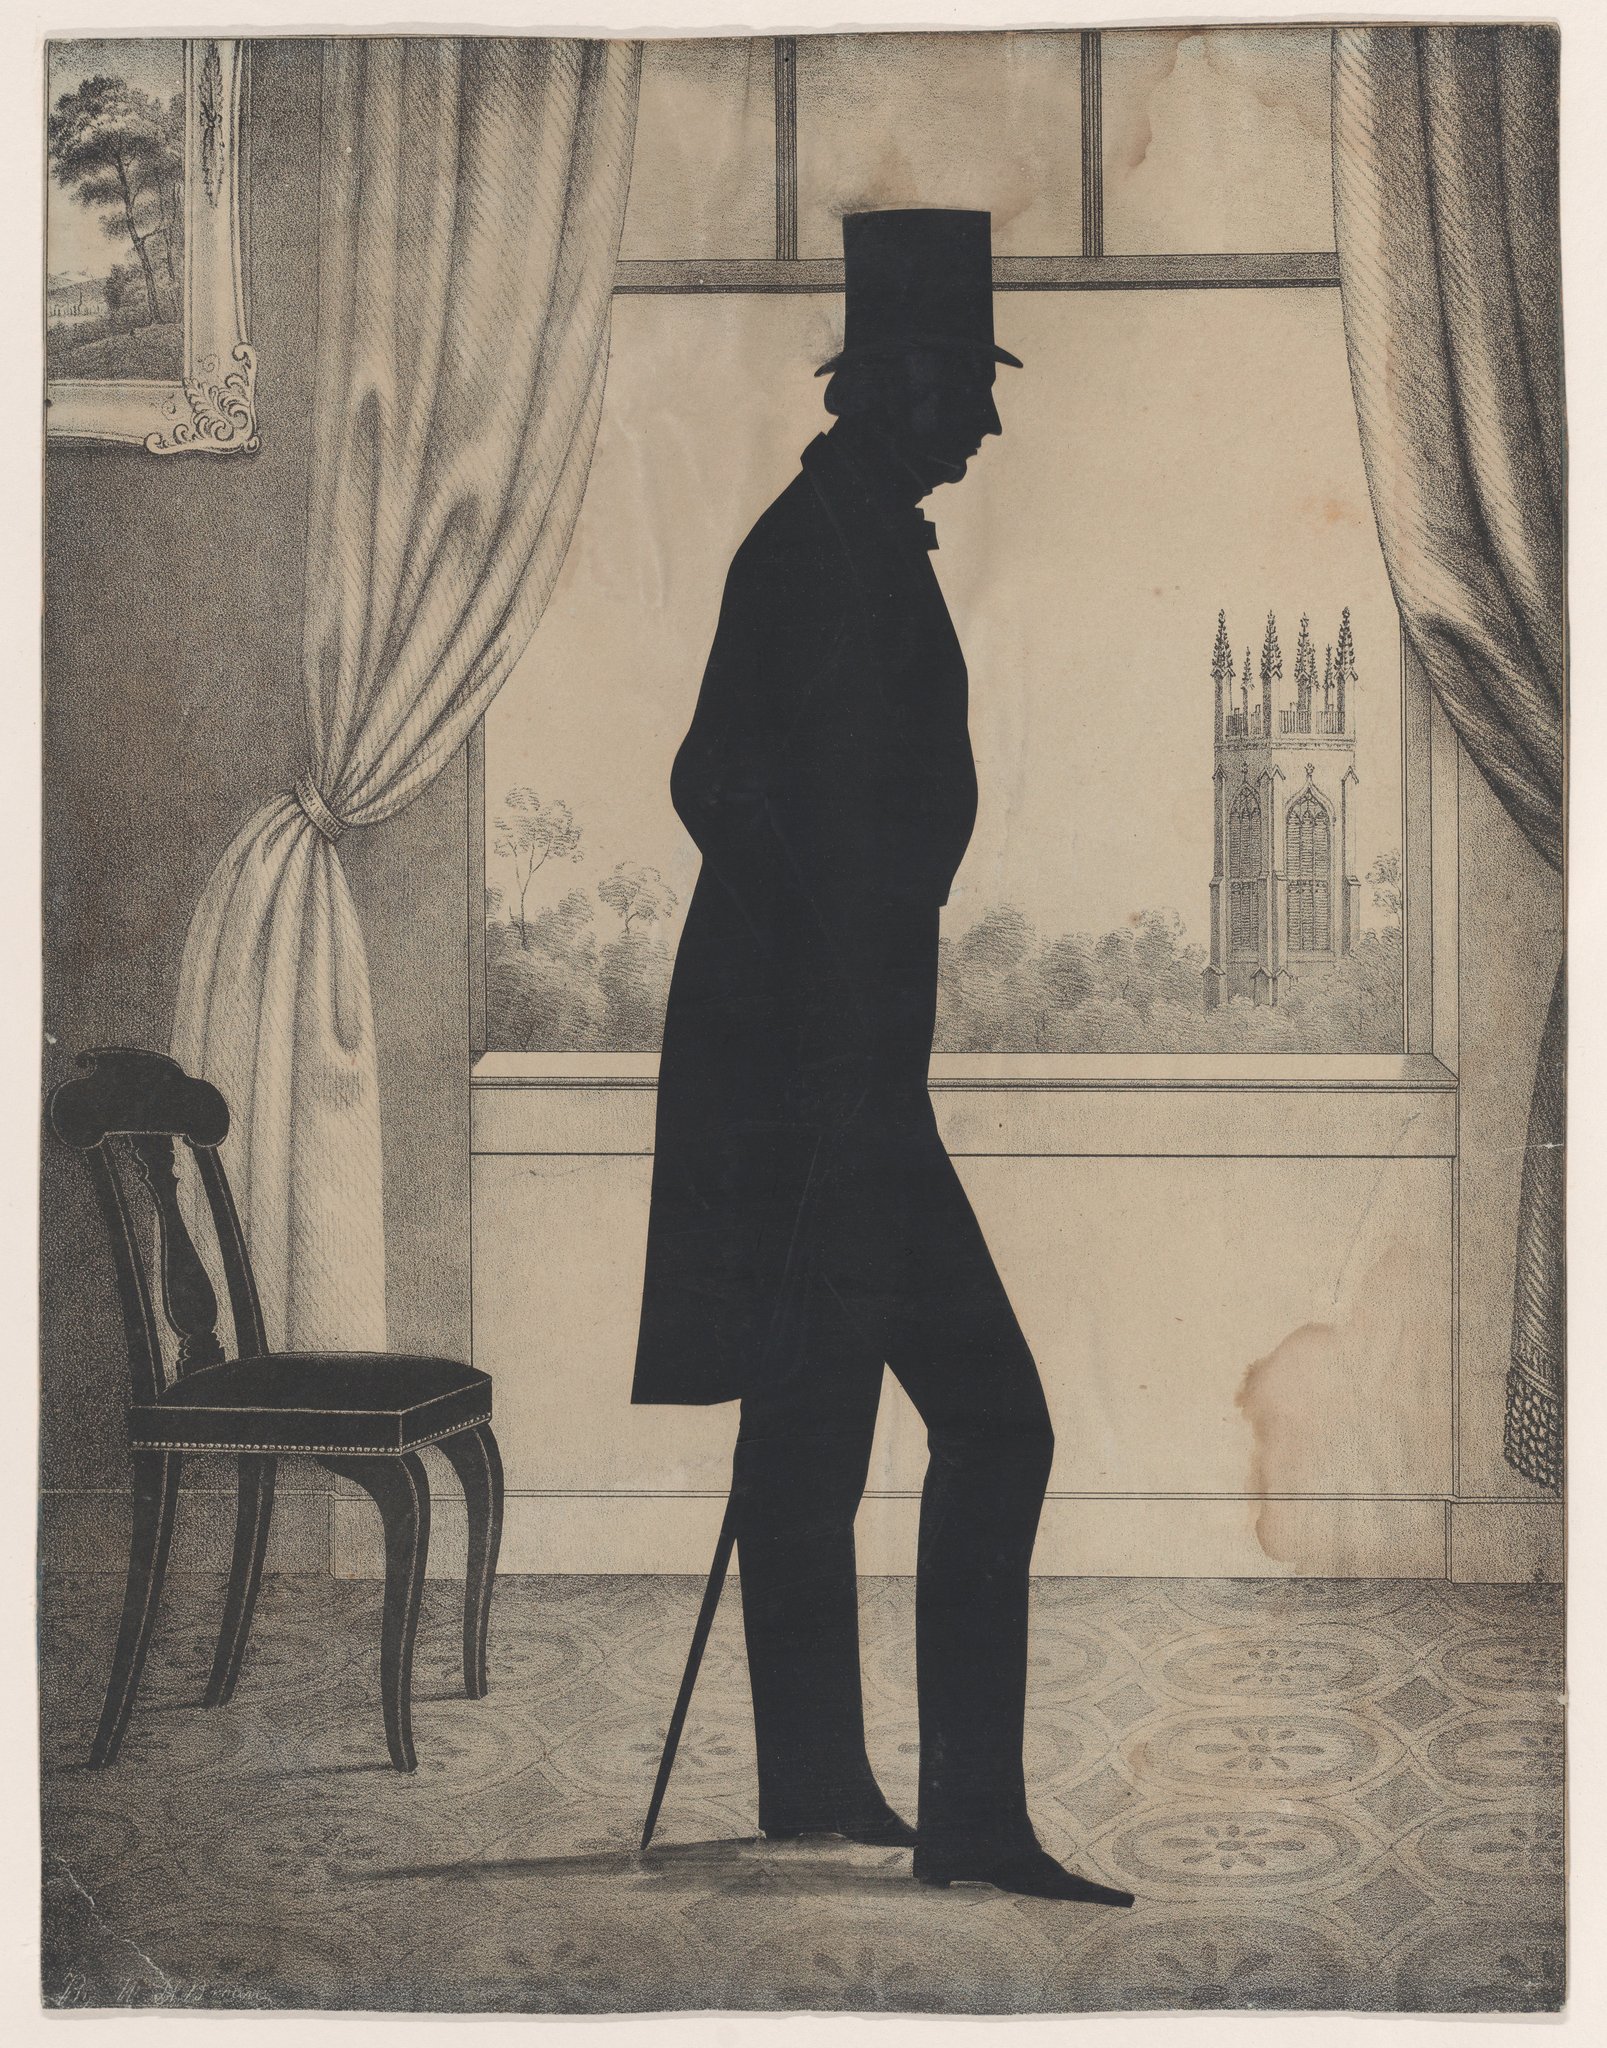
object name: cut paper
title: Silhouette of Nathaniel Babson of Gloucester, Massachusetts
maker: william henry brown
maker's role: artist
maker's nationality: american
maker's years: 1808-1883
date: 1828-1883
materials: paper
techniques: cutting, lithograph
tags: men